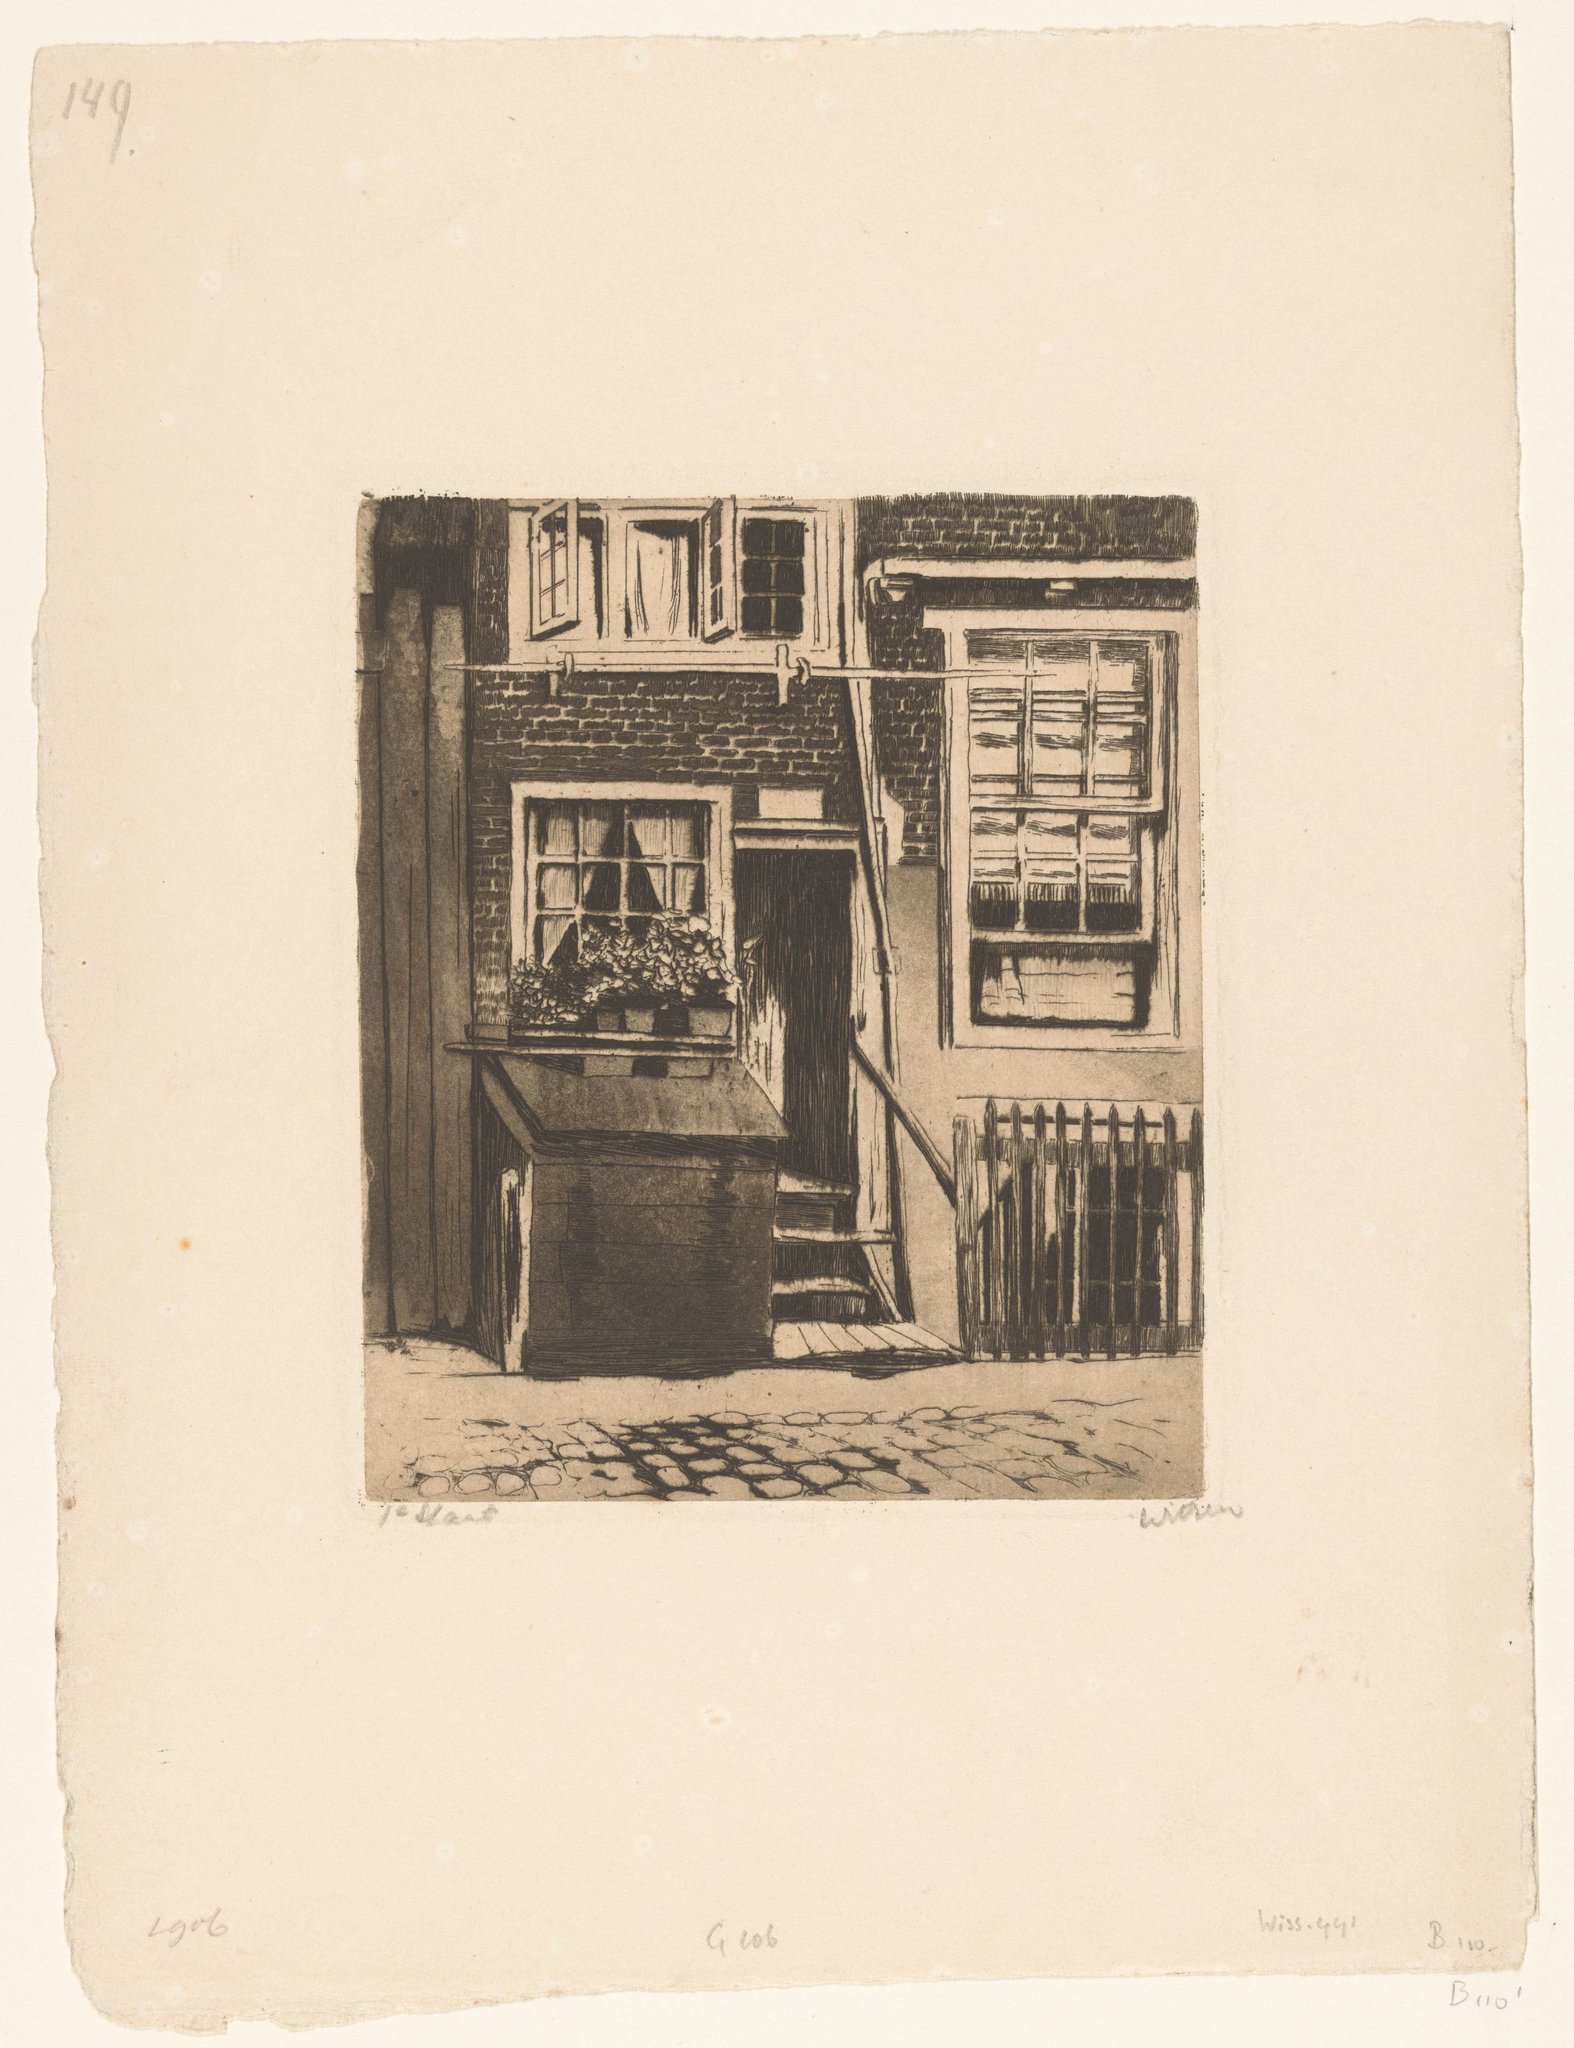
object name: print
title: Gezicht op de Krom Boomssloot 71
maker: willem witsen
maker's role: draughtsman, painter, print maker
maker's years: 1860-1923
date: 1906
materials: paper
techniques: aquatint, etching, intaglio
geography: amsterdam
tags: urban housing, open window, closed door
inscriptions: inscription: ‘1e staat’, signature: ‘Witsen’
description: Rechts is een deel van de Korte Dijkstraat 2 afgebeeld.